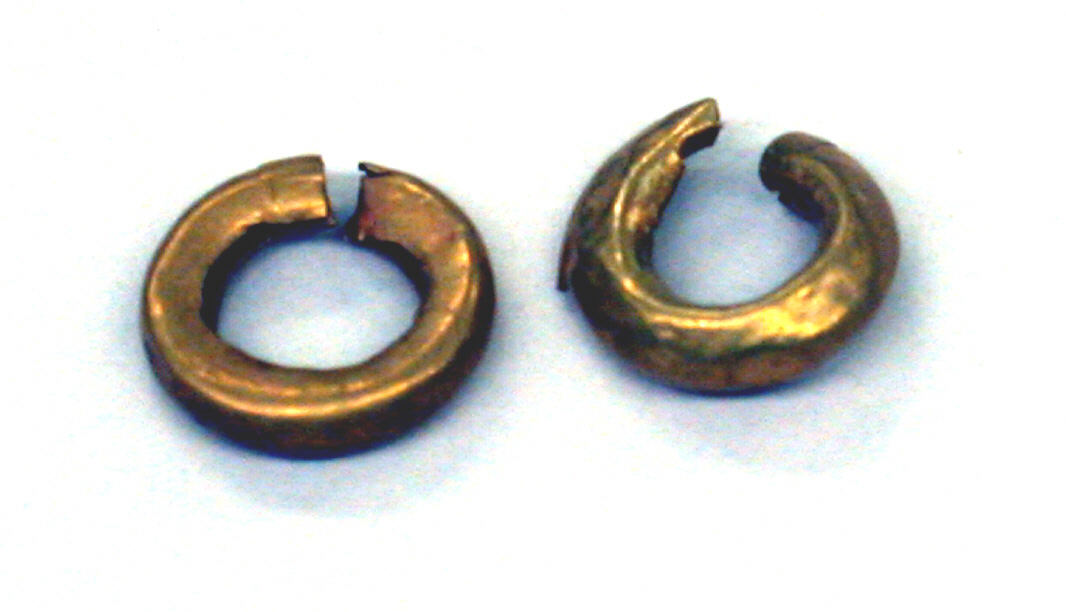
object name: ear ornament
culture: visayas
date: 1301-1500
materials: gold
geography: philippines